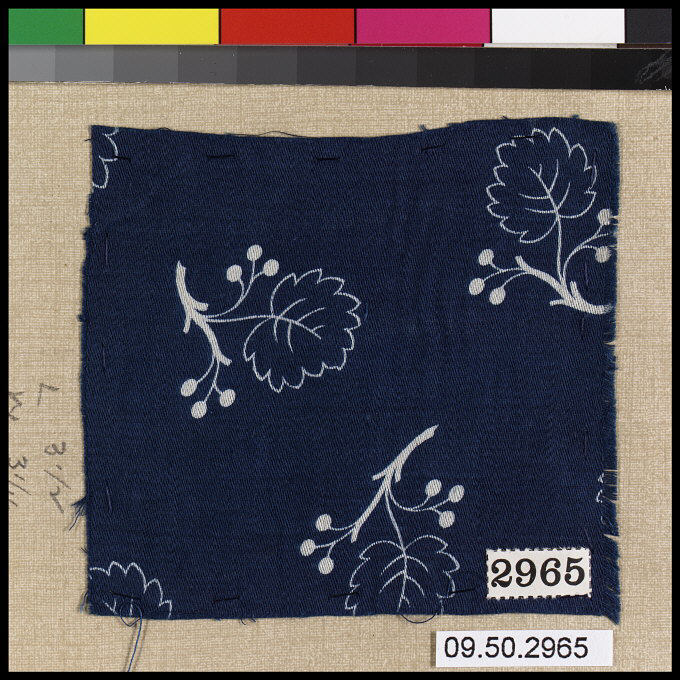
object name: piece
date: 1801-1900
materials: cotton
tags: leaves